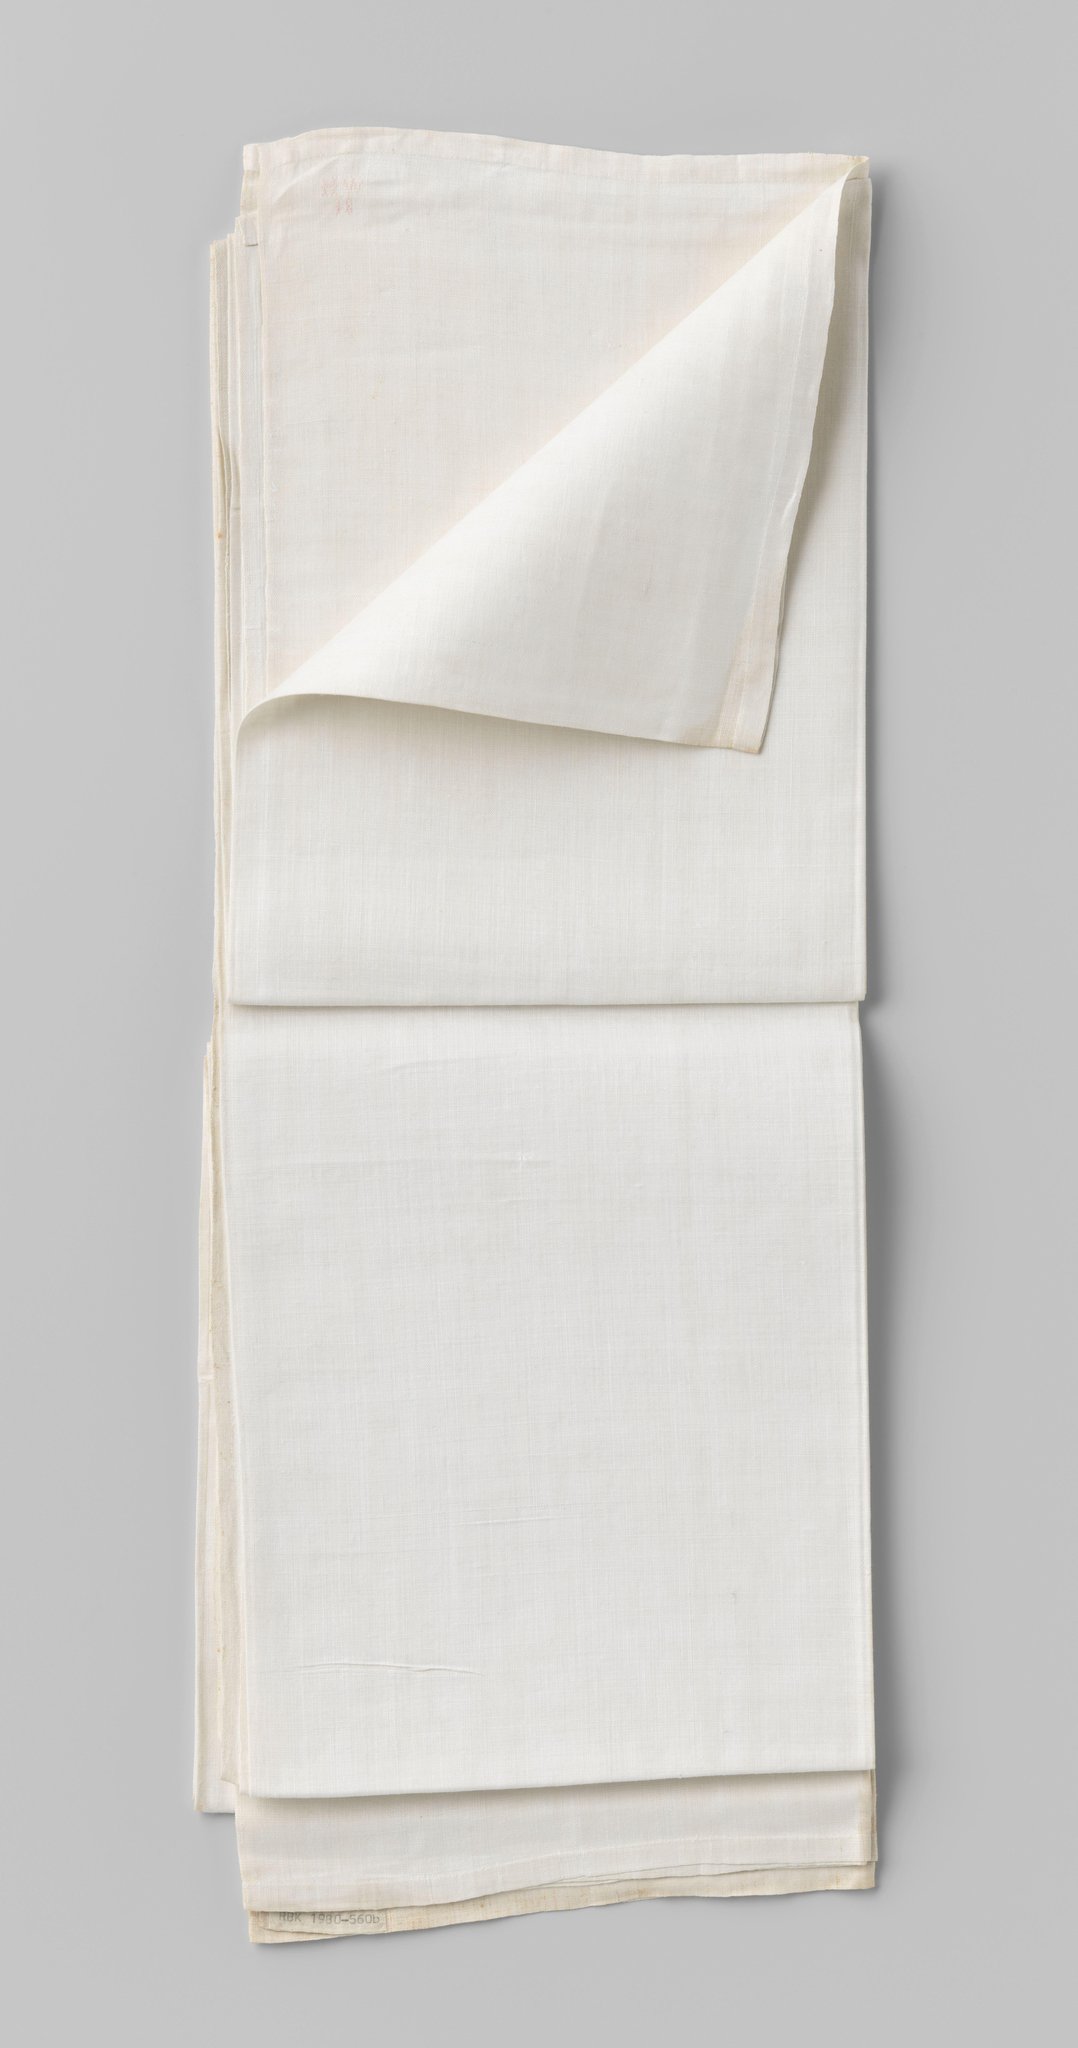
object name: beddenlaken, laken object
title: Kinderlaken. Merk: HW 18.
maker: Anonymous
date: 1852-1860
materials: linen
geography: northern netherlands